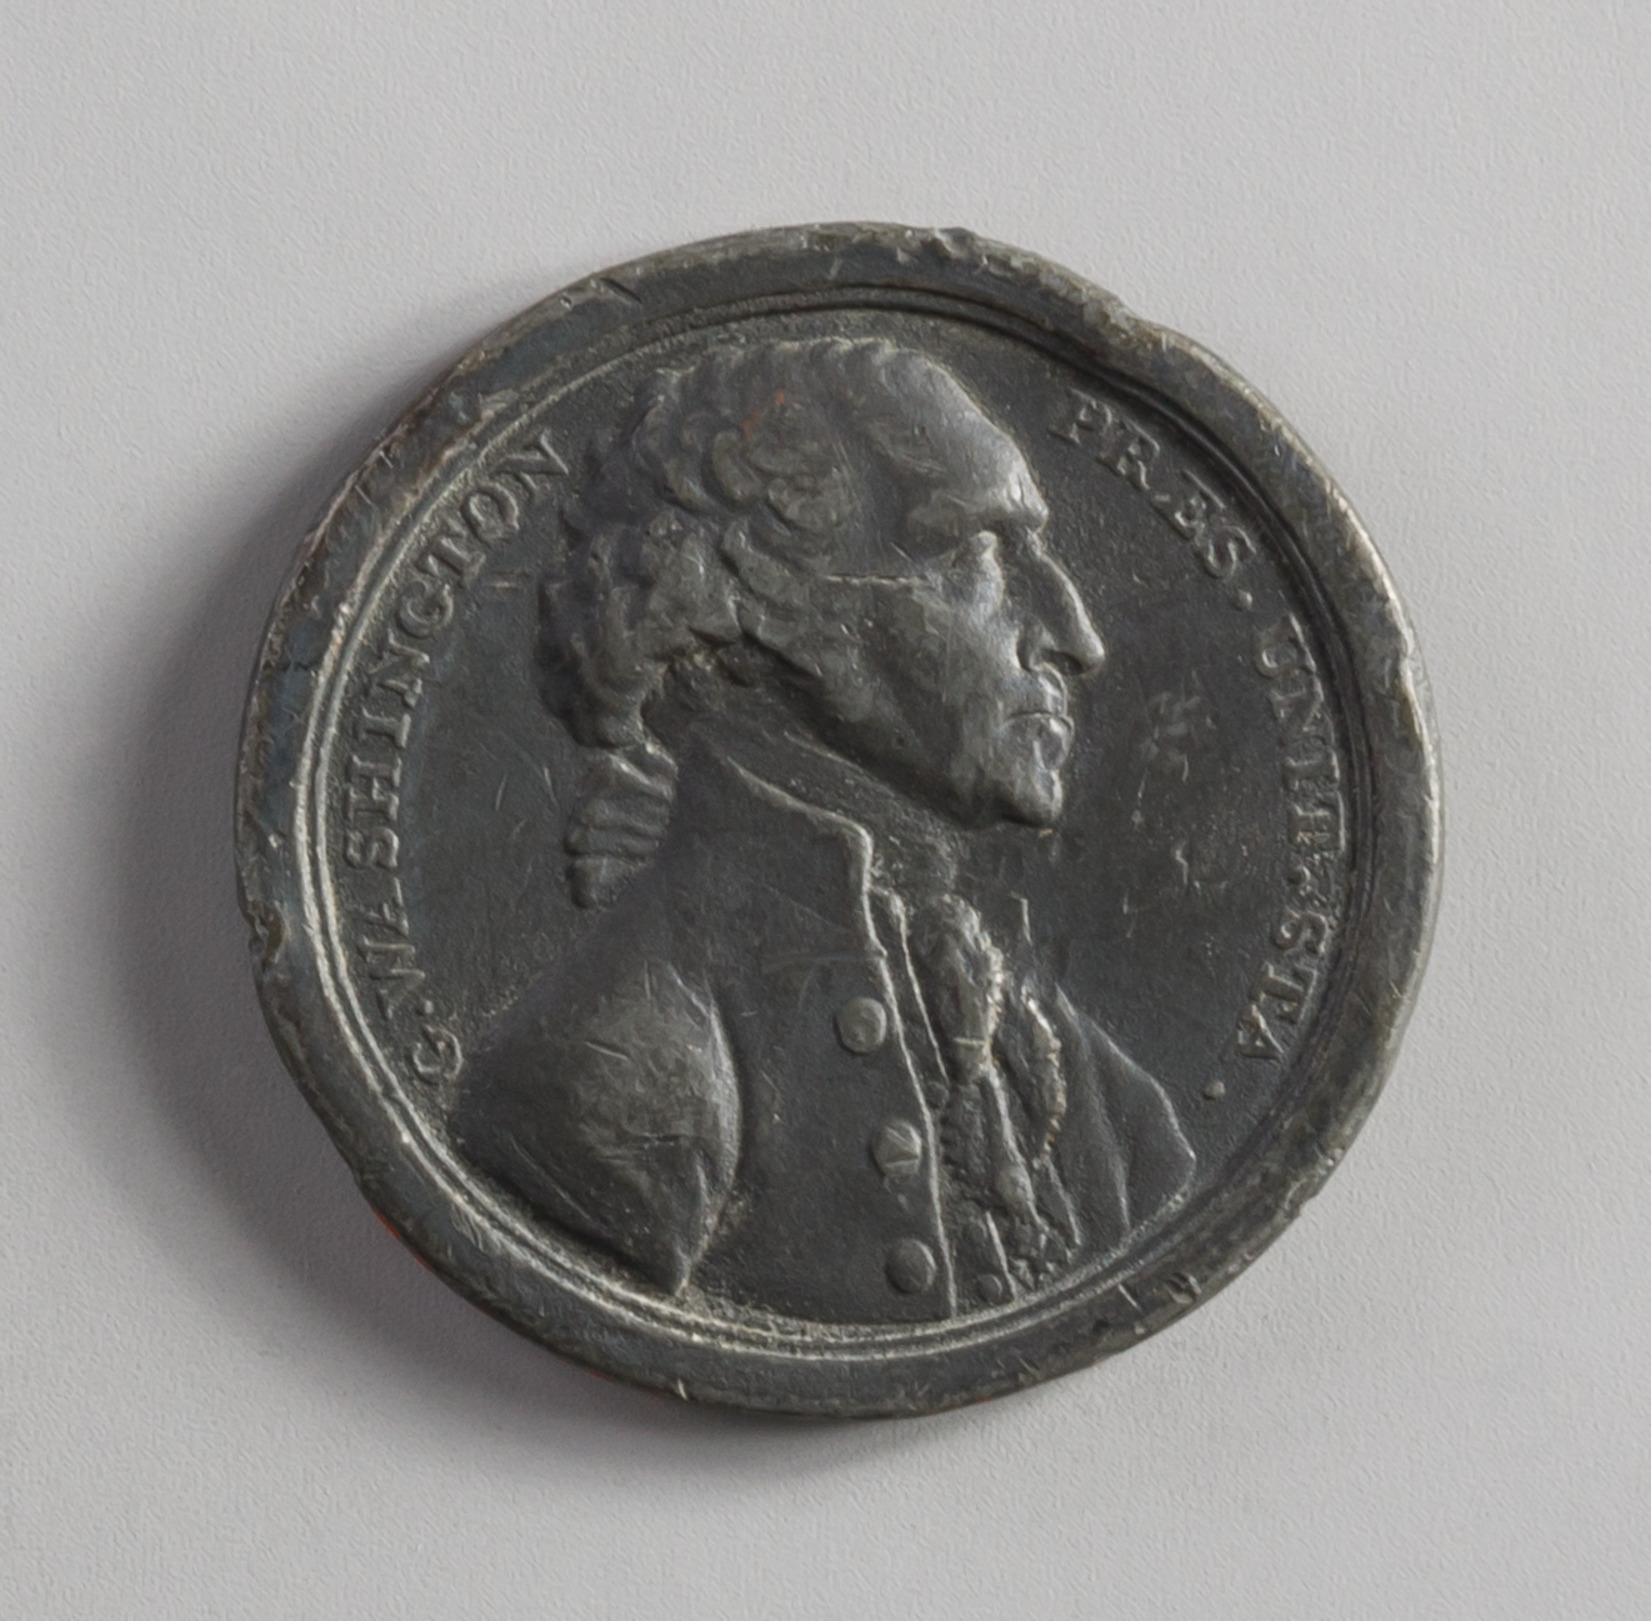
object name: medal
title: Medal Commemorating Washington's Resignation of the Presidency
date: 1797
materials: lead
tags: george washington,profiles